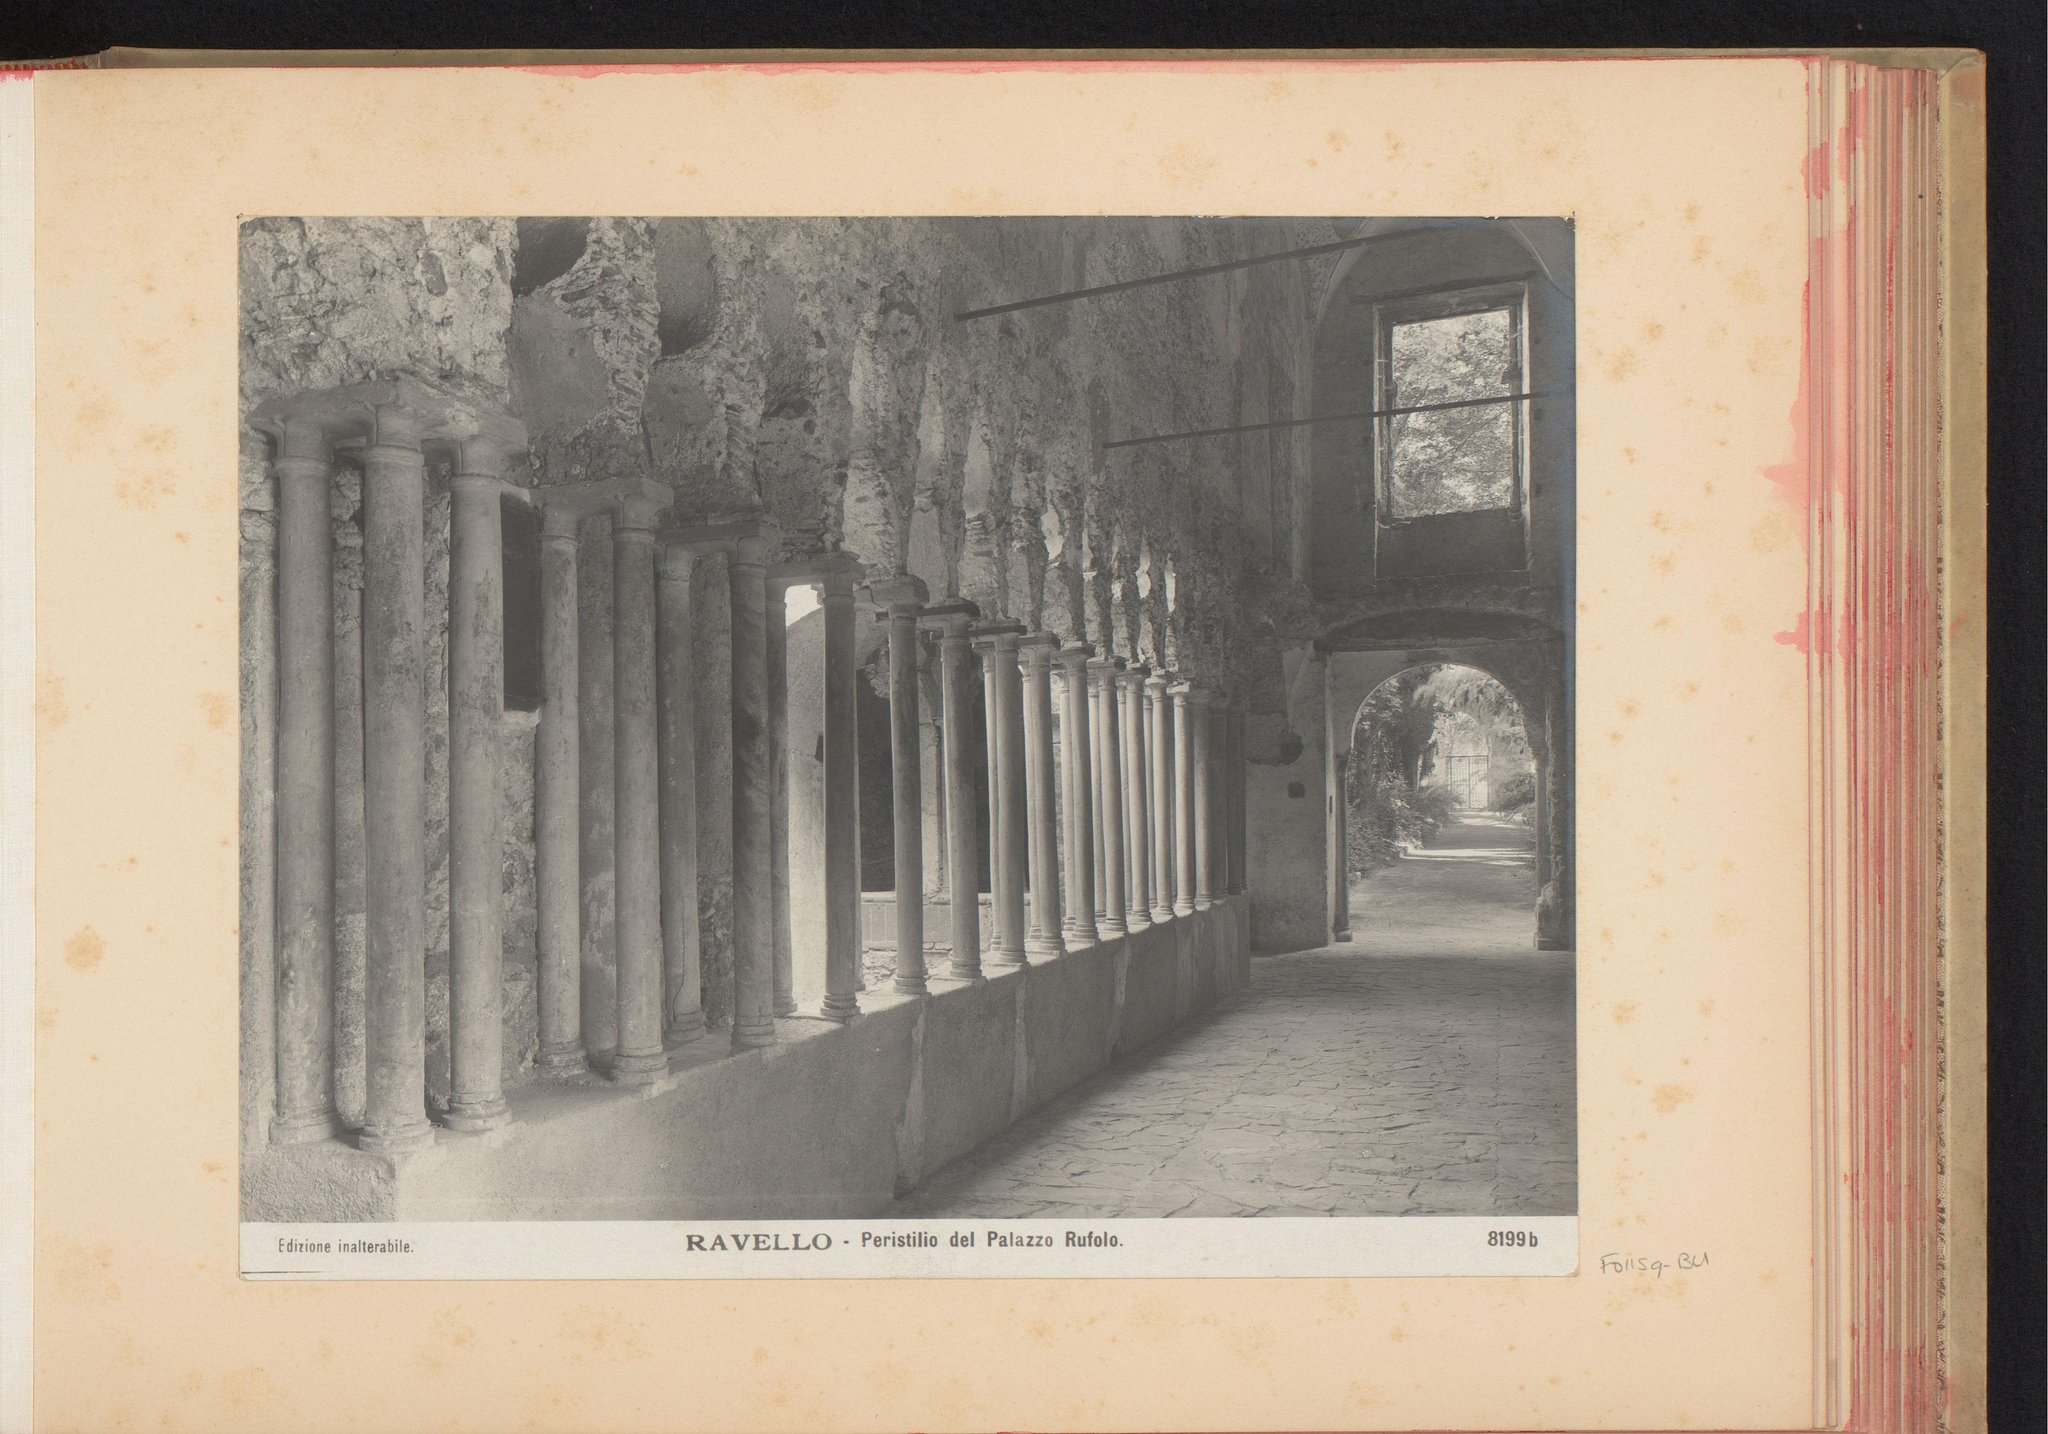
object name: photograph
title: Ravello - Peristilio del Palazzo Rufolo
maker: Anonymous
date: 1875-1907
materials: photographic support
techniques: gelatin silver print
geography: villa rufolo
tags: colonnade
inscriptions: number: ‘8199b’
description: Onderdeel van Fotoalbum met opnames van bezienswaardigheden en kunstwerken in Italië.